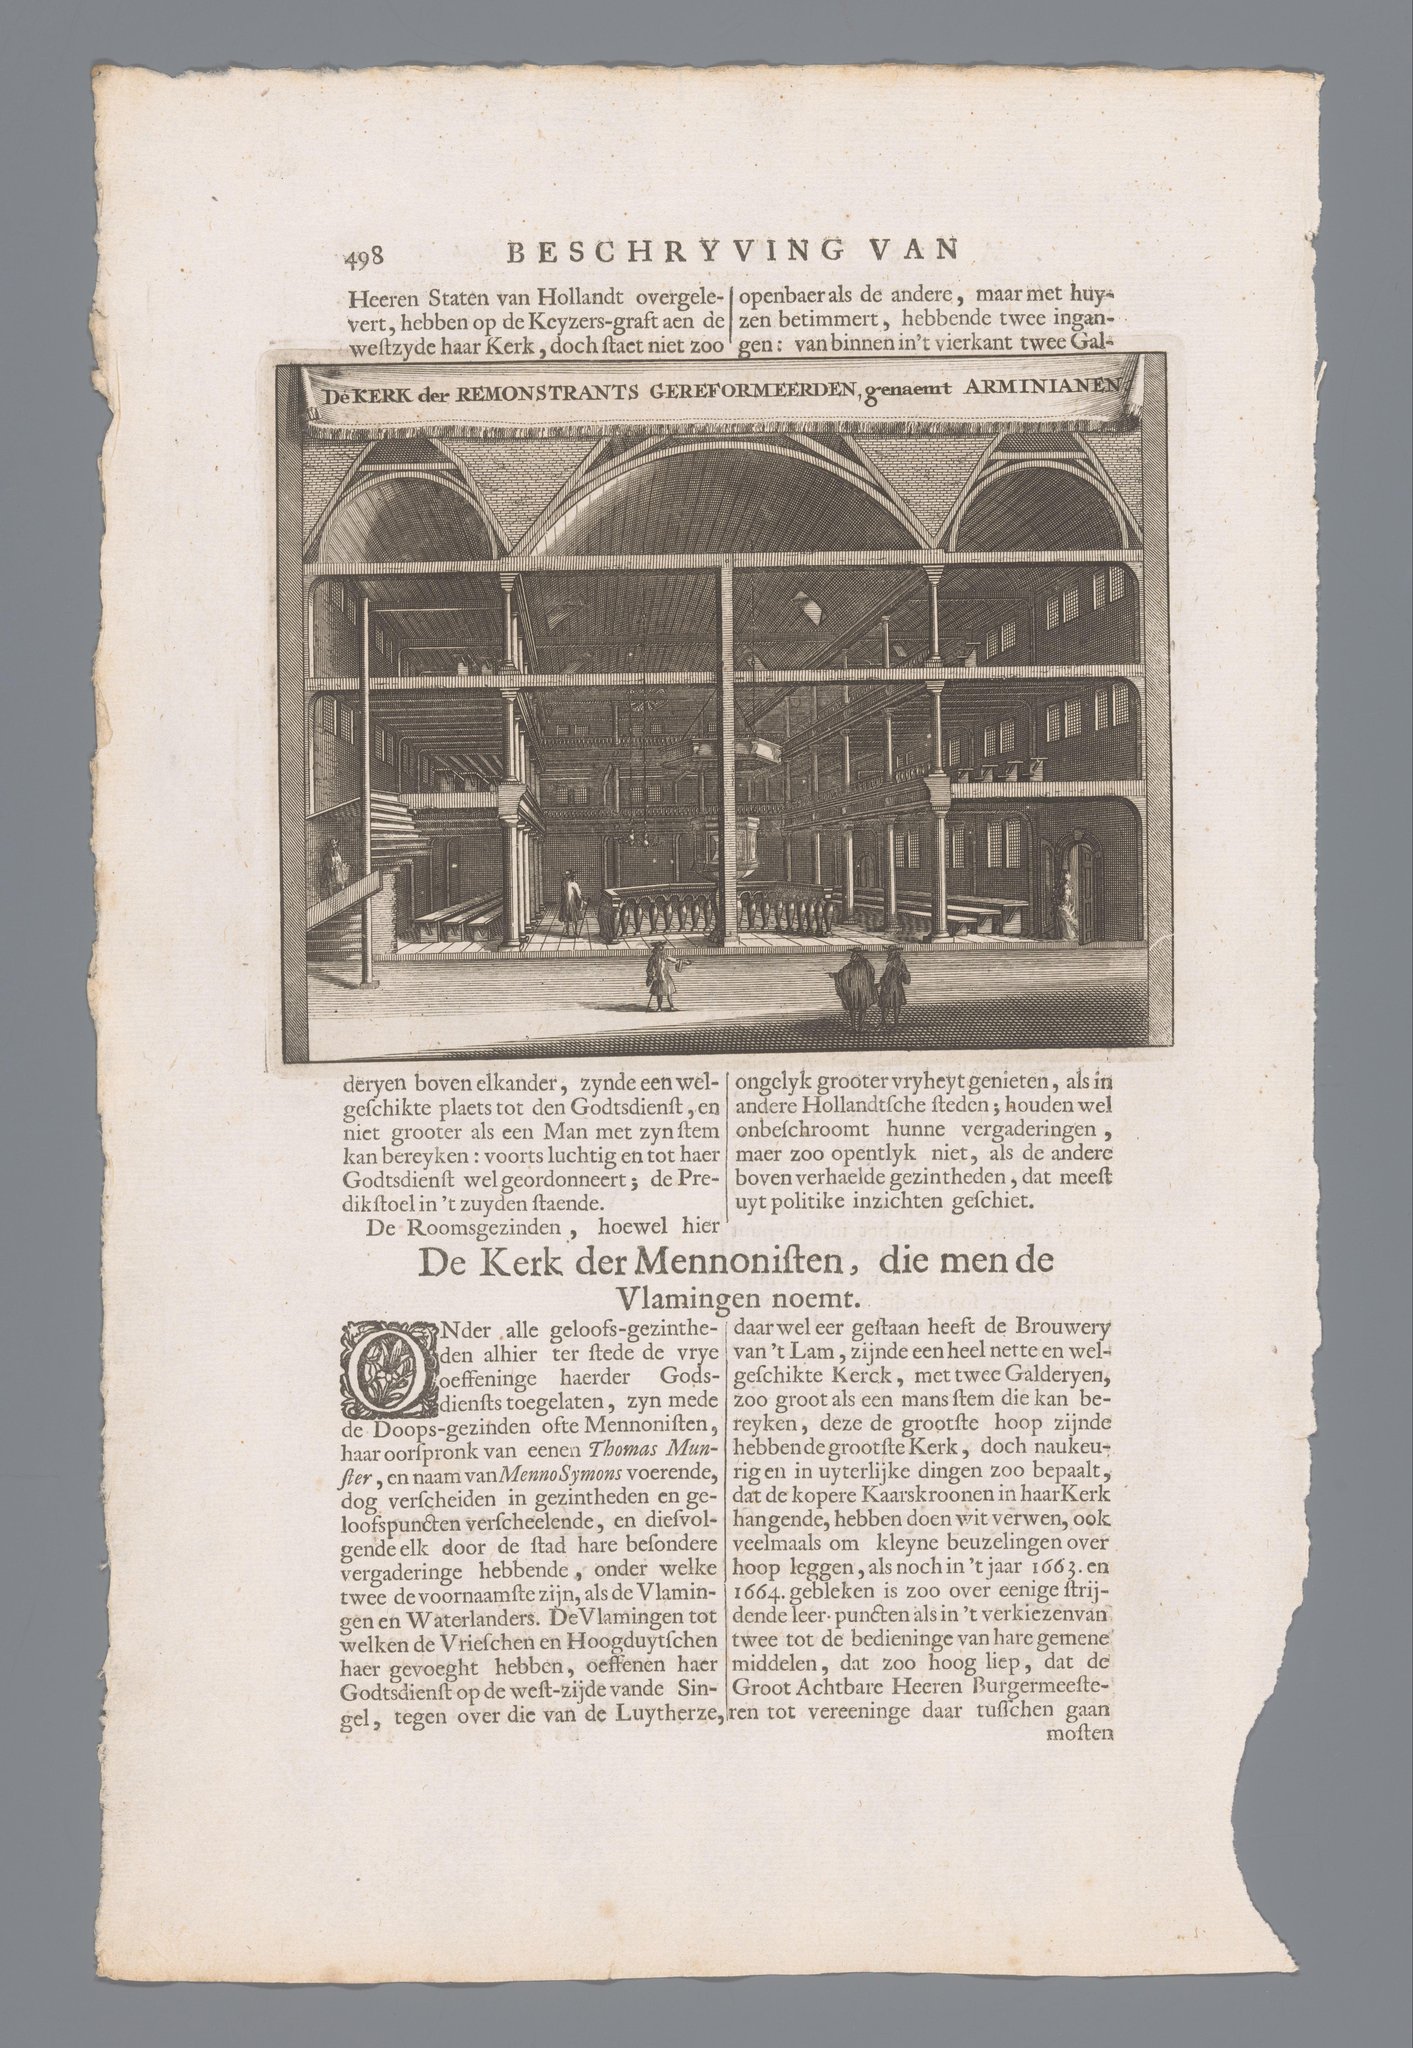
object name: book illustration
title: De Kerk der Remonstrants Gereformeerden, genaemt Arminianen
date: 1726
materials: paper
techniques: engraving, etching, letterpress printing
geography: amsterdam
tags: protestant churches and denominations (with name), interior of church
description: Prent verschenen in: Commelin, Caspar. Beschryvinge van Amsterdam, zynde een naukeurige verhandelinge van desselfs eerste oorspronk uyt (…). 2 dln. 2e druk. Amsterdam: Andries van Damme et al., 1726.